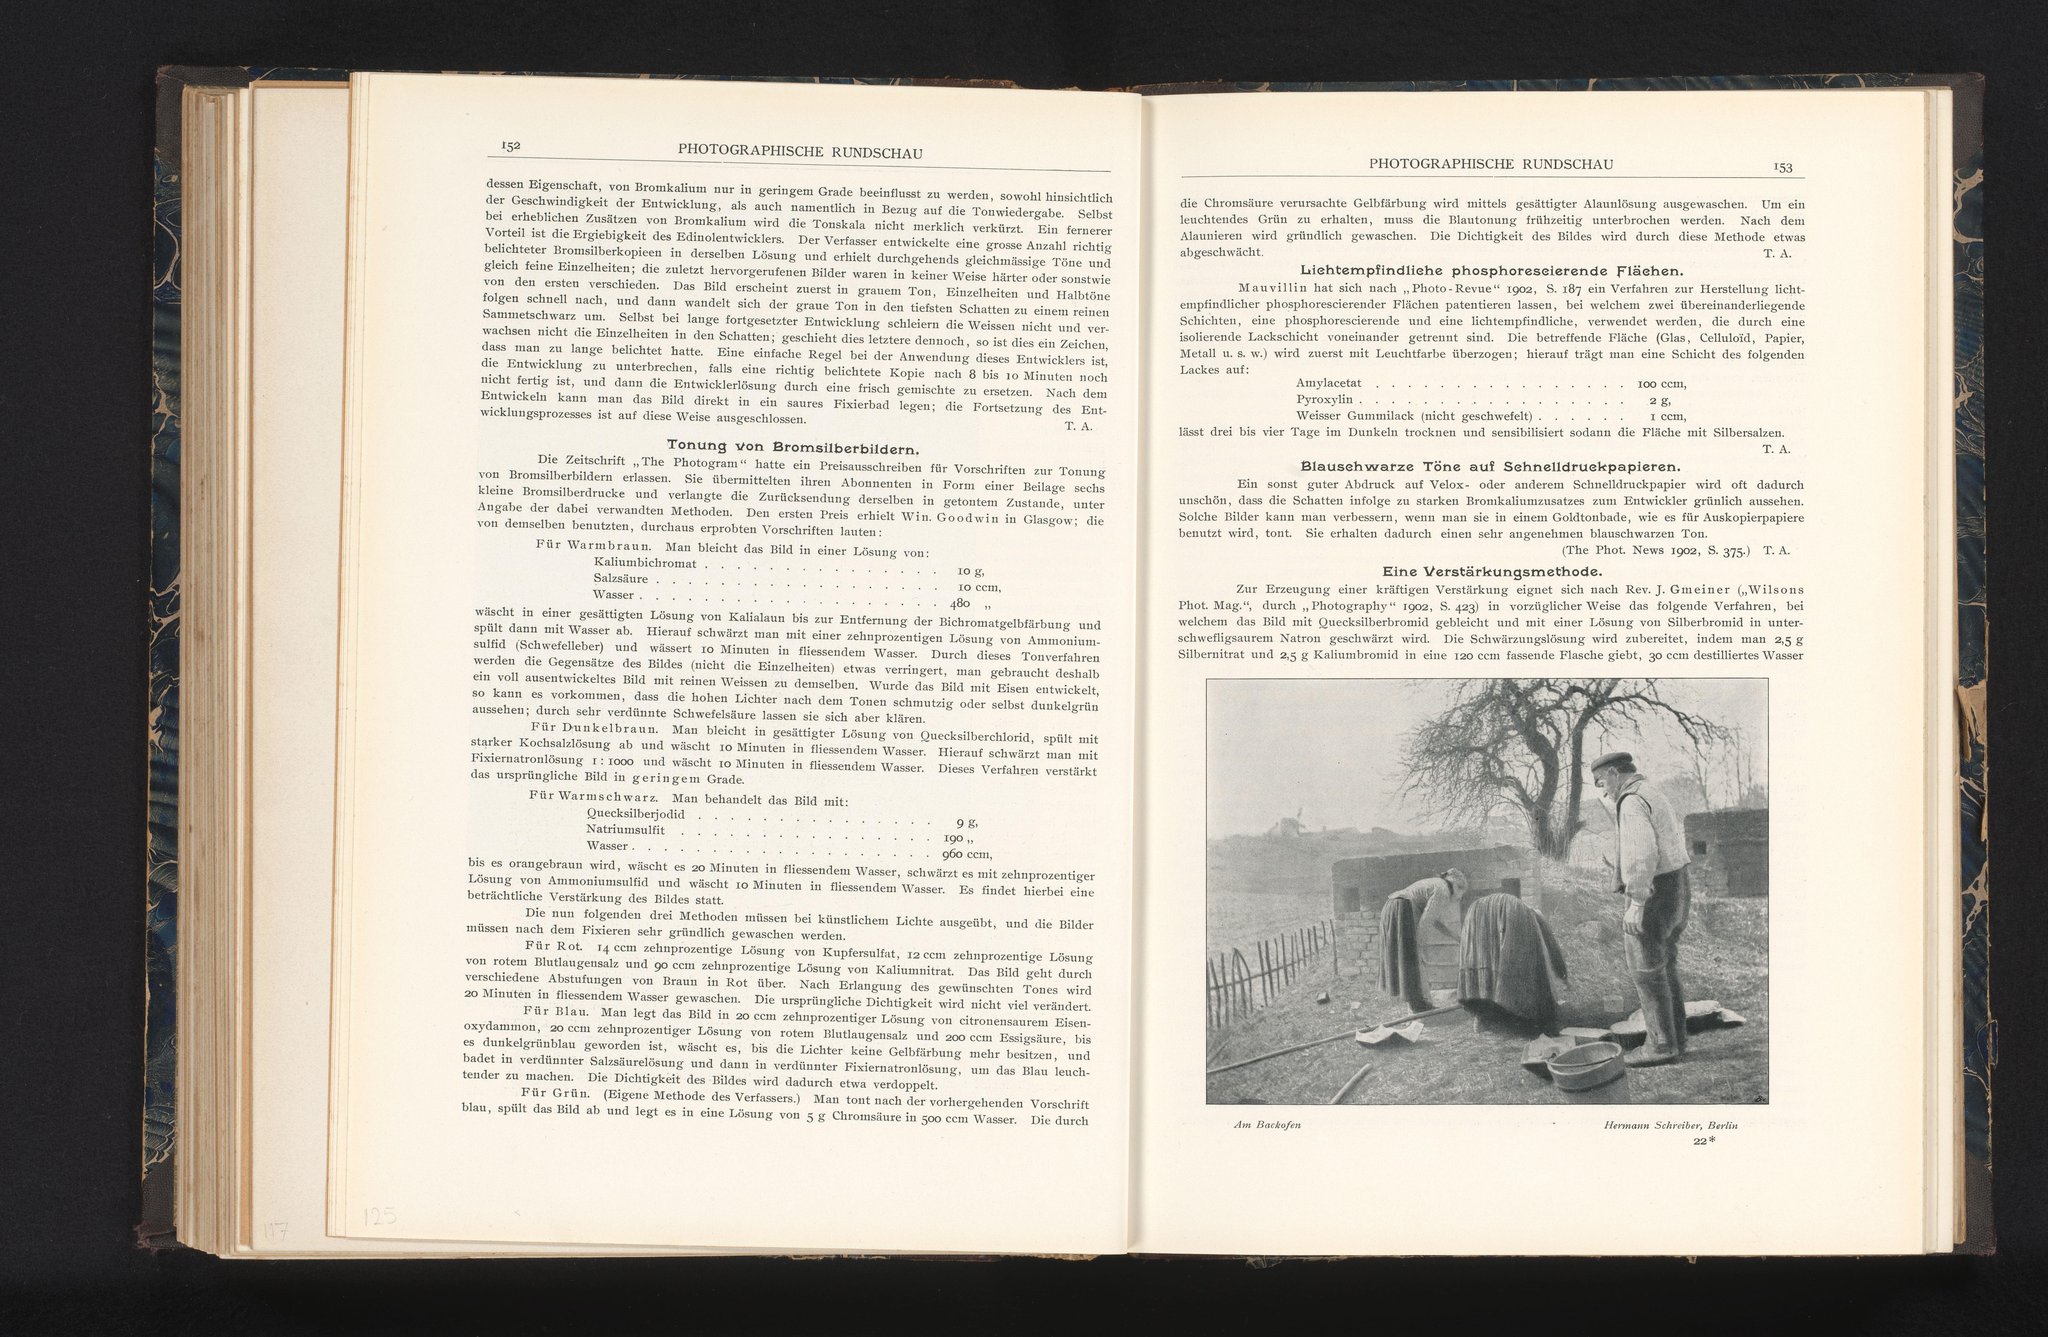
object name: photomechanical print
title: Am Backofen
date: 1897-1902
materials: paper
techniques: autotype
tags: adult woman, adult man, oven ~ kitchen - cc - in the open air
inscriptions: monogram: ‘BX’